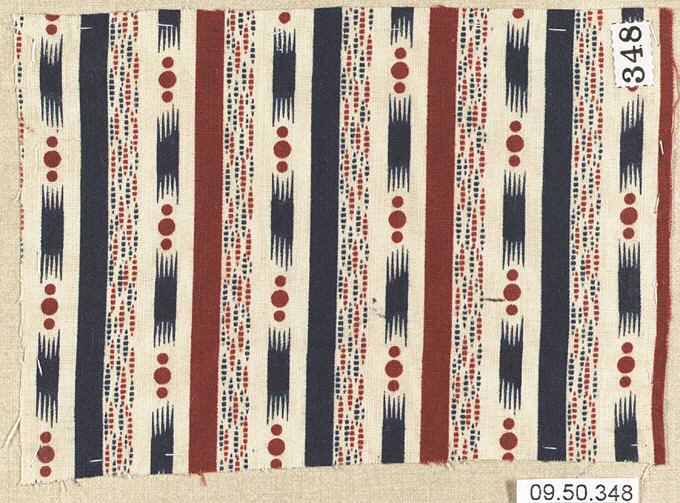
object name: piece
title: Piece (one of 116)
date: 1801-1900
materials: cotton